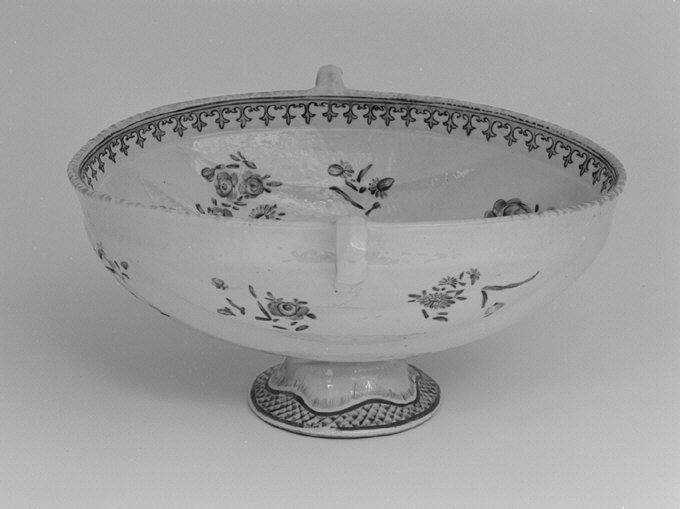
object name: dish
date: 1740-1770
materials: hard paste porcelain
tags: flowers